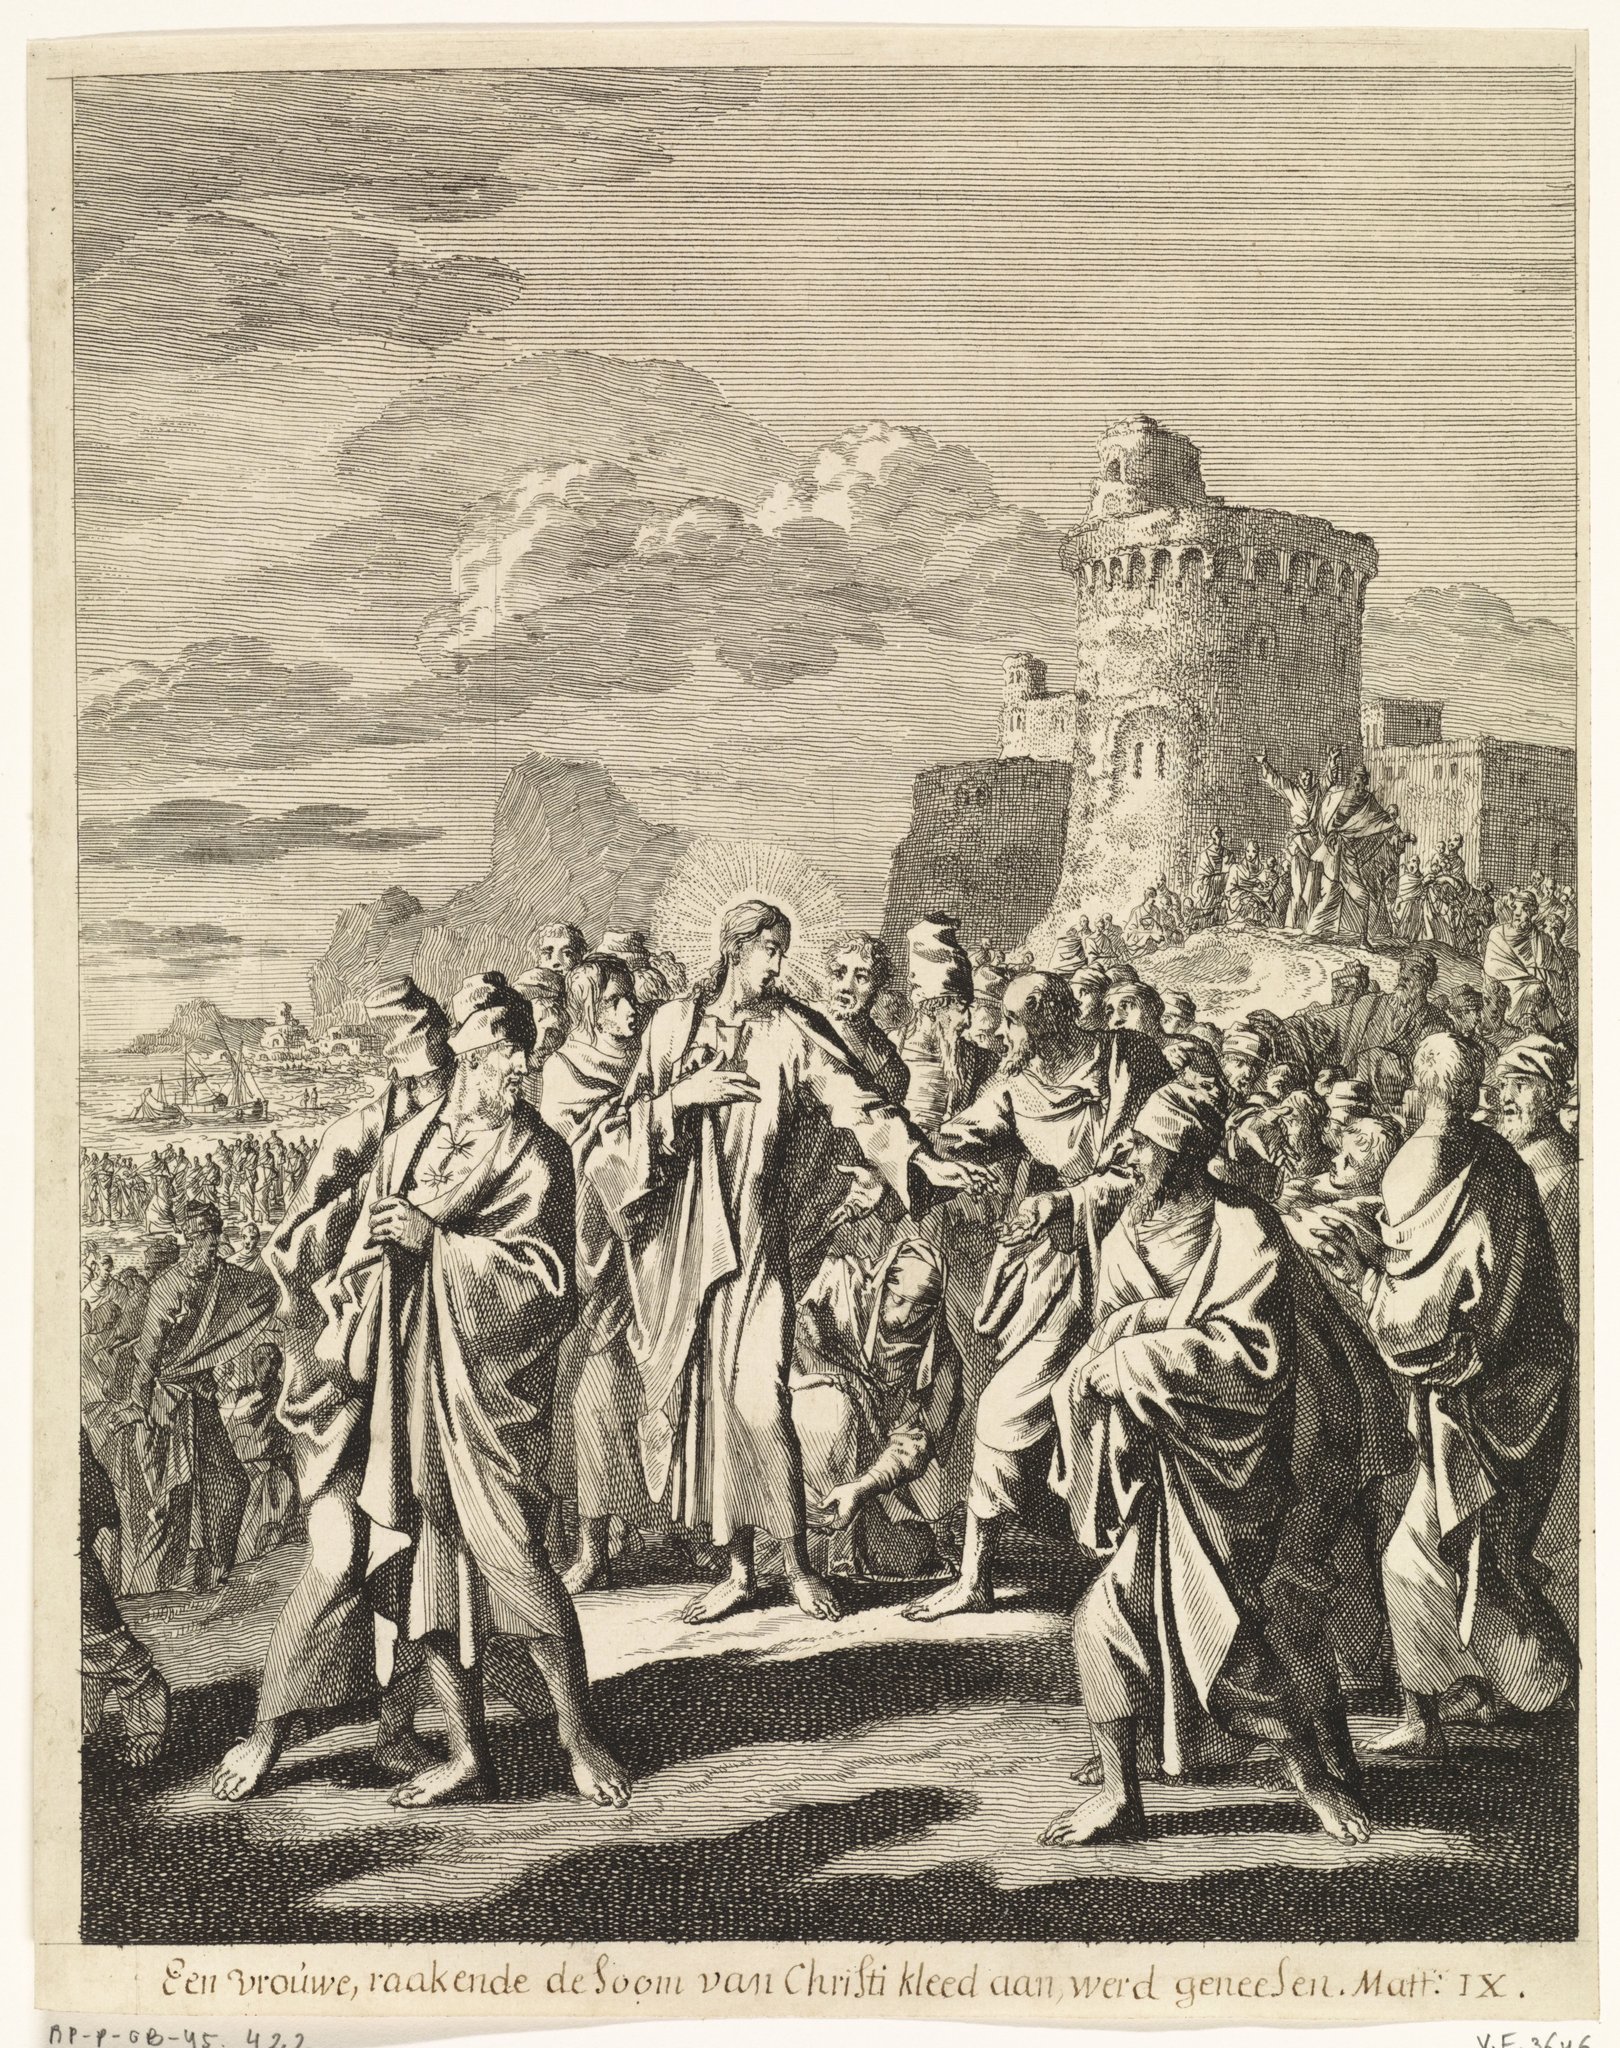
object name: print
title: Christus geneest de zieken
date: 1708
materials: paper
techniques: etching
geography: amsterdam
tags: miracles of christ ~ healing the sick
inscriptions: collector's mark: Lugt 2228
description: Proefdruk van een prent welke is opgenomen als illustratie in: Historiae Celebriores Veteris Testamenti. Christoph Weigel, 1708.